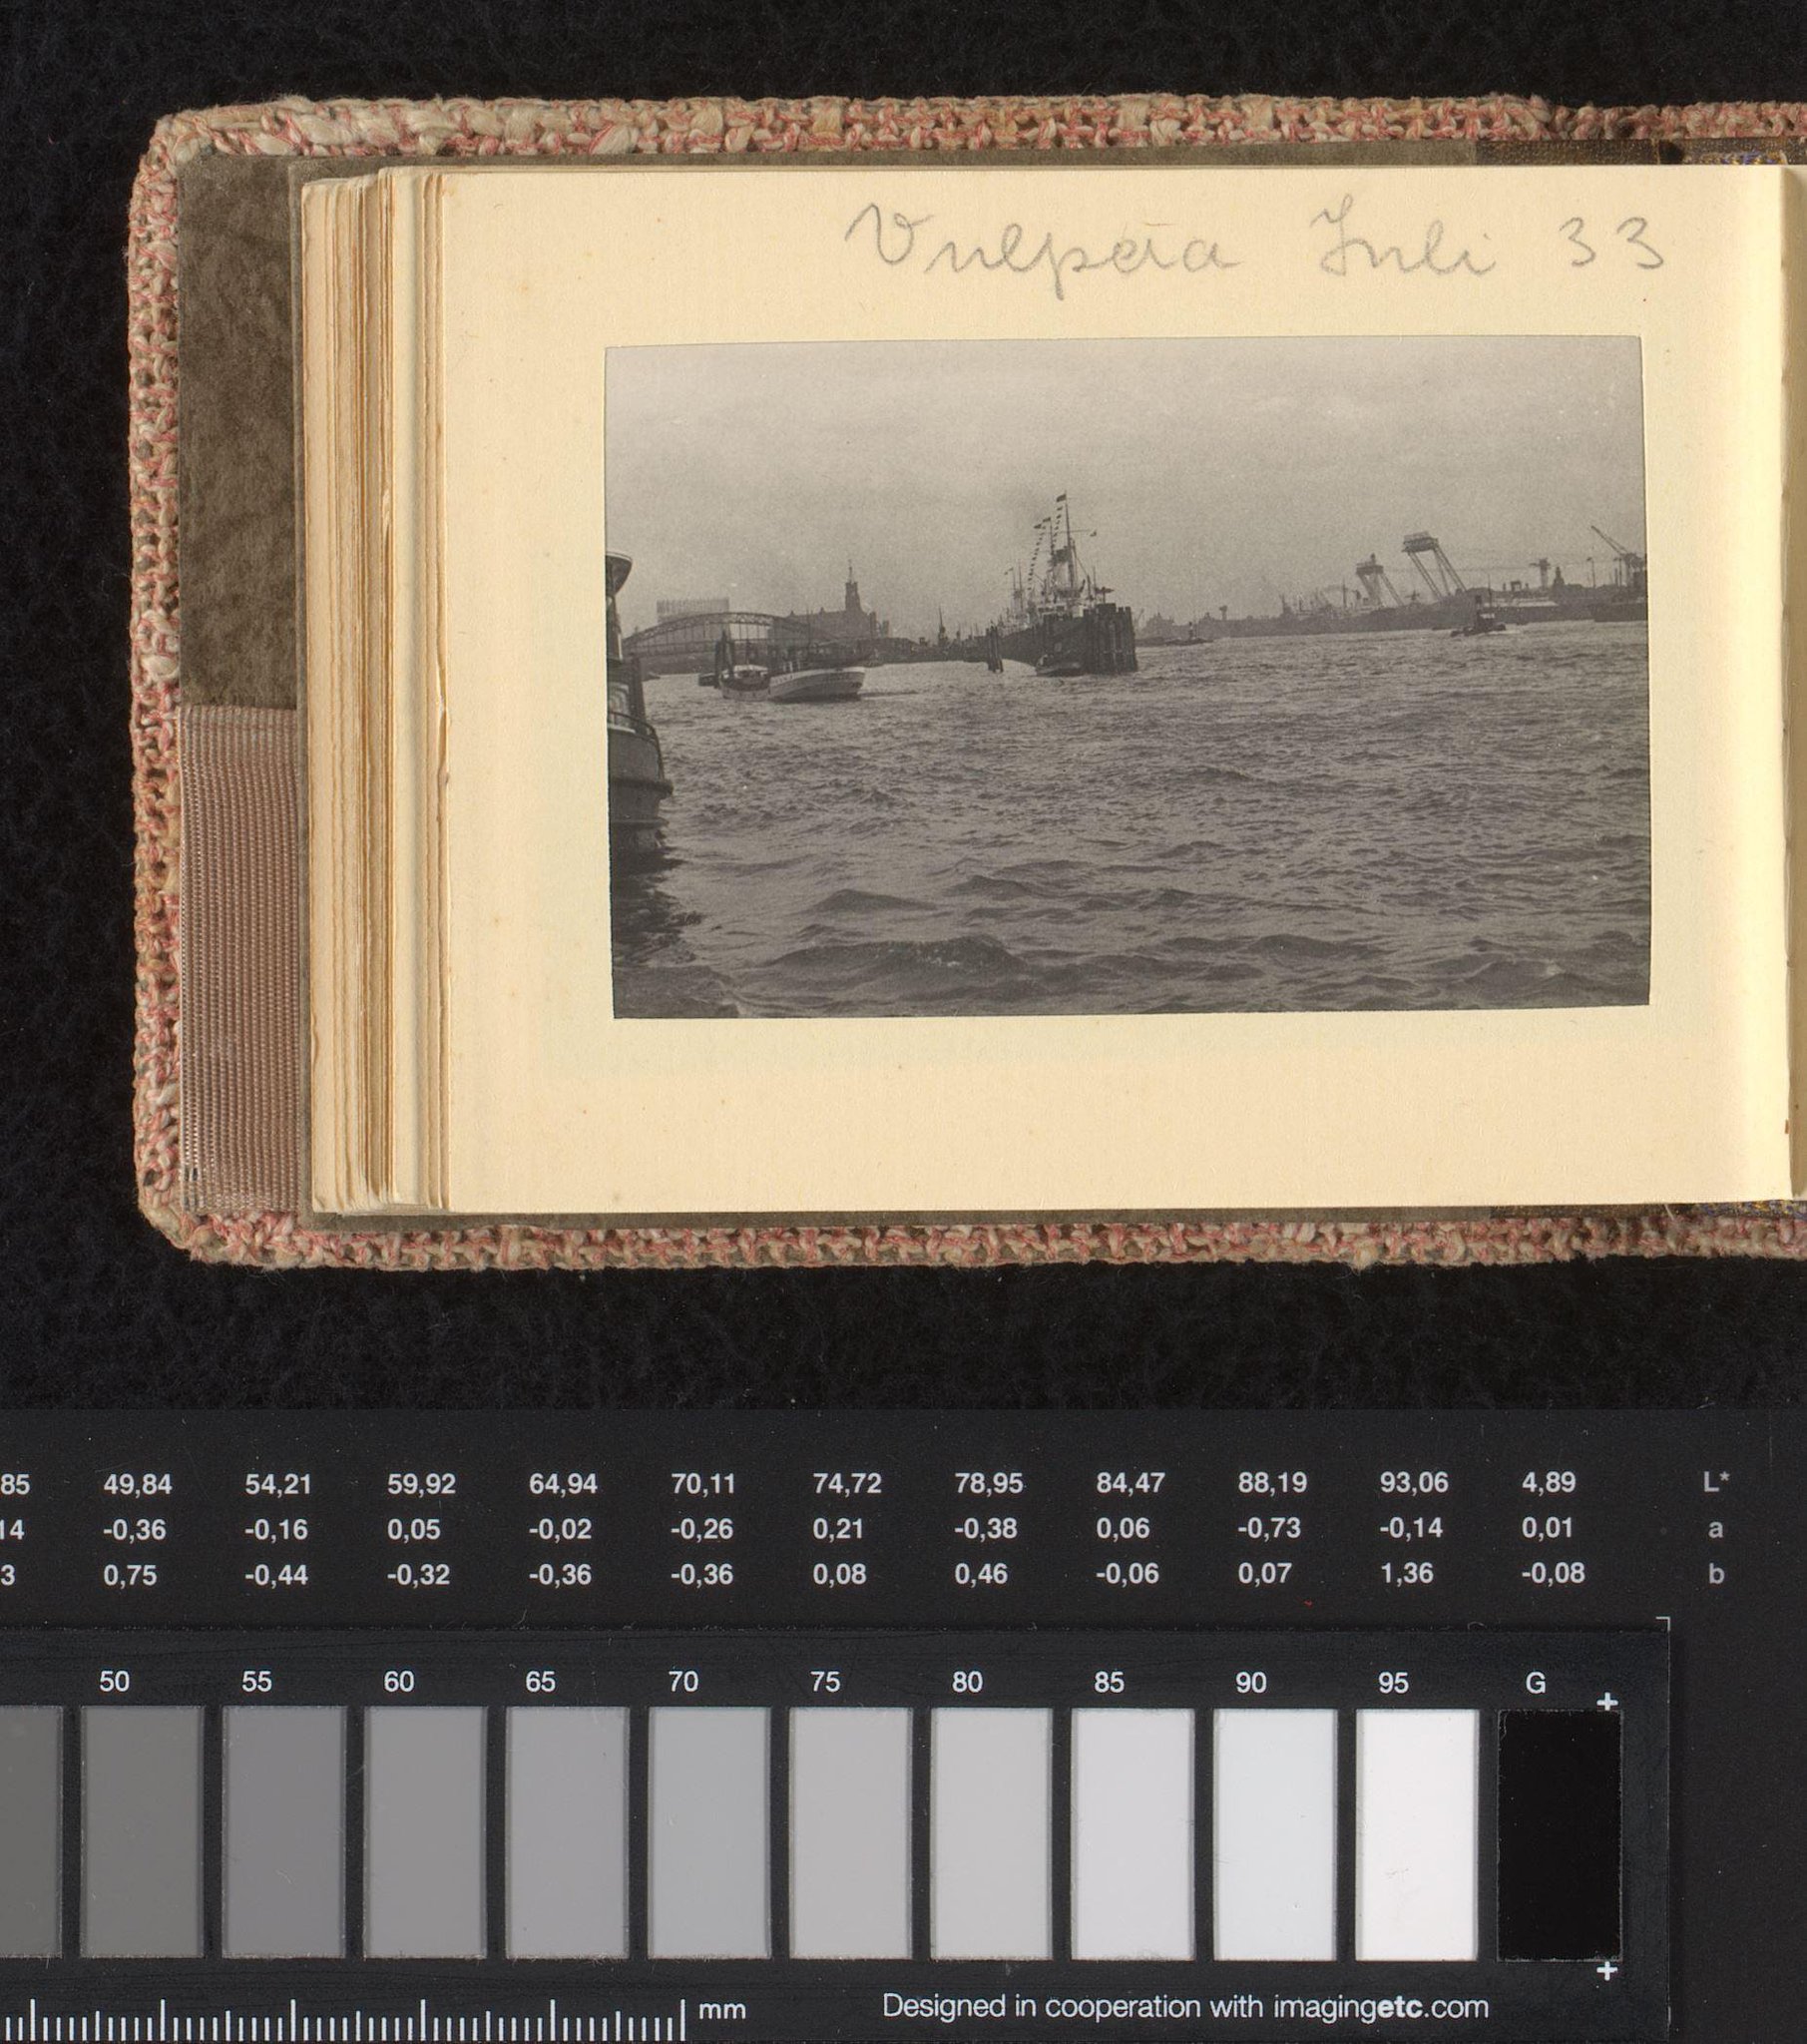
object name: photograph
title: Haven van Hamburg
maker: else wachenheimer-moos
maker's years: 1895-1944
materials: paper, photographic support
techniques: gelatin silver print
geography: switzerland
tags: harbour, the family travelling, on holiday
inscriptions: inscription: ‘Vulpera Juli 1933’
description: Albumblad bevat een foto. Onderdeel van het fotoalbum Hamburg zomer 1933.